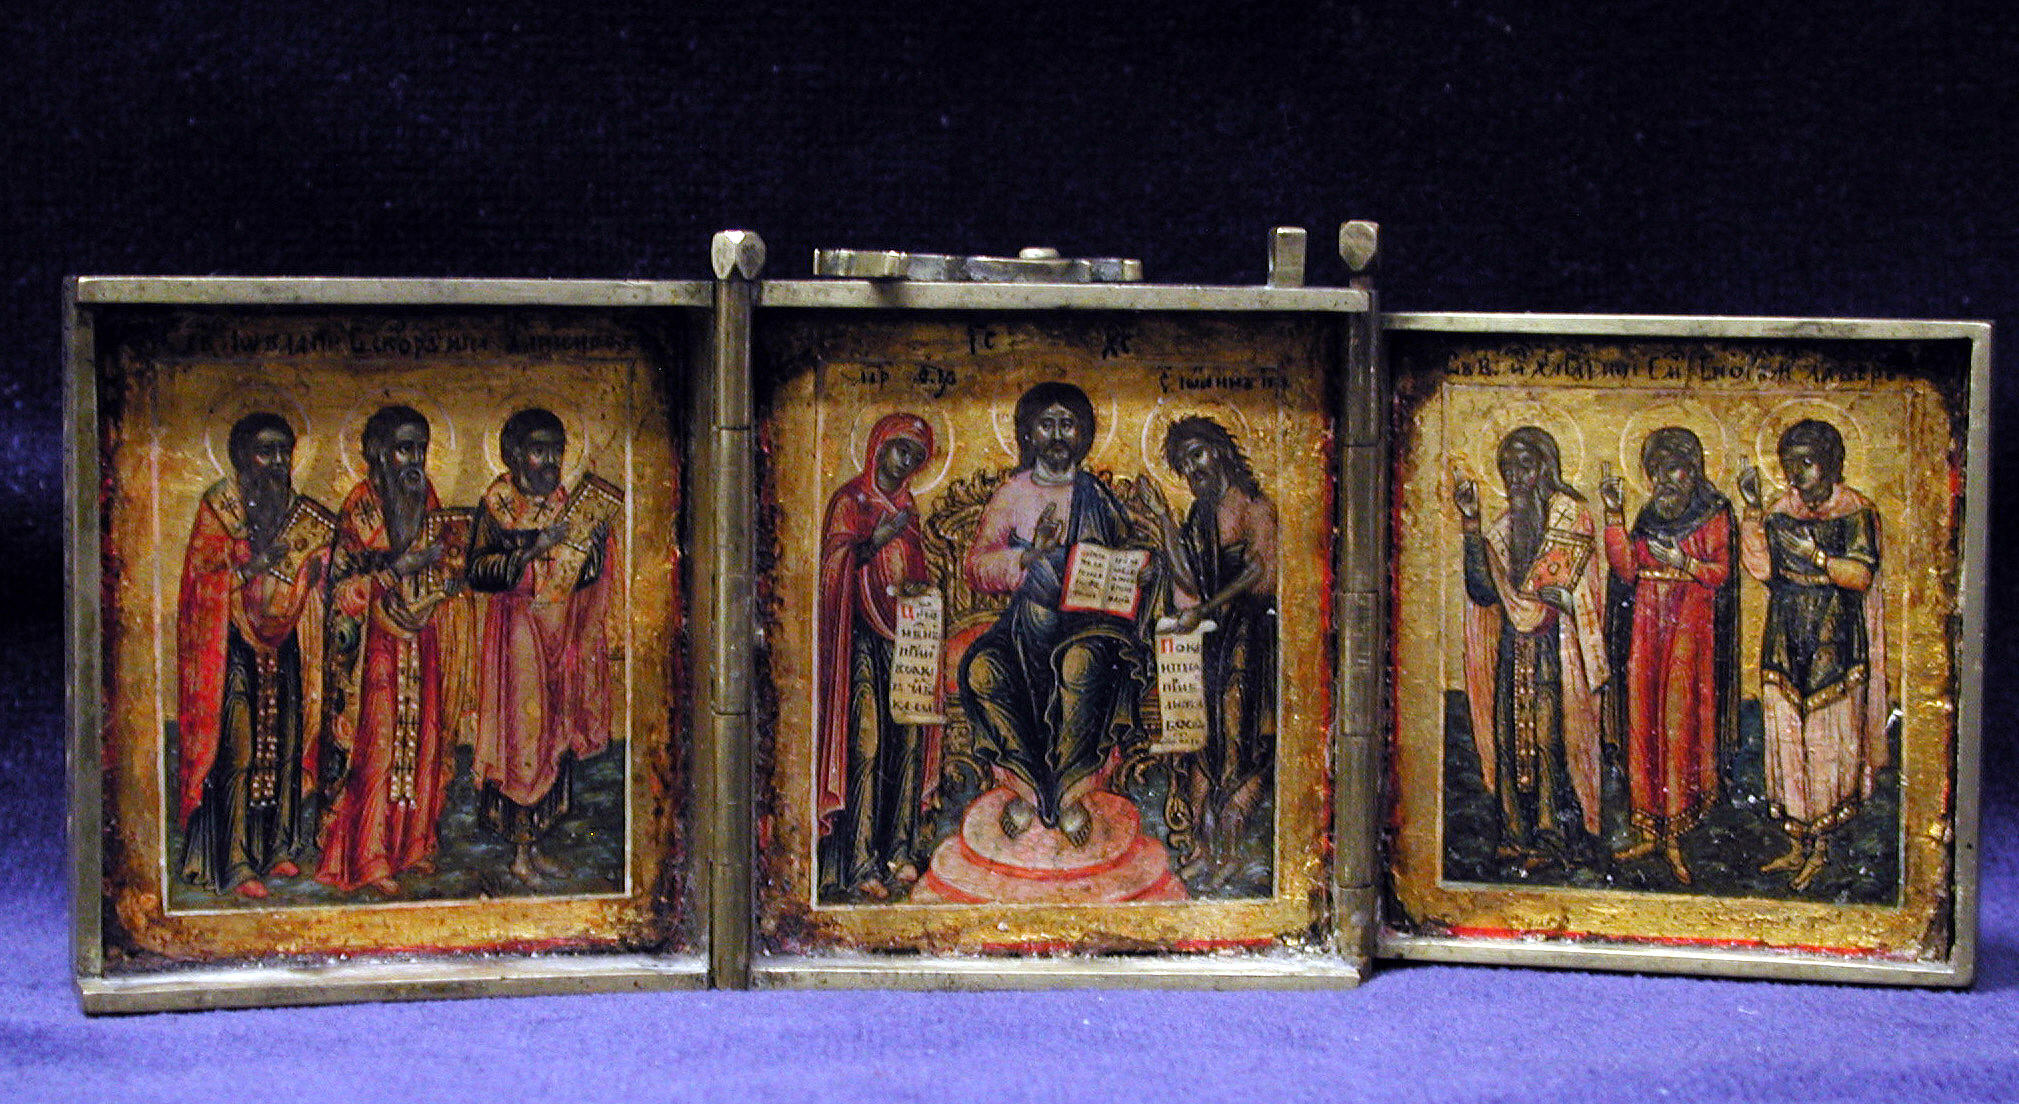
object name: traveling triptych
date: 1734-1766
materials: brass, gilt, silver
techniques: painting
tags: christ,saints